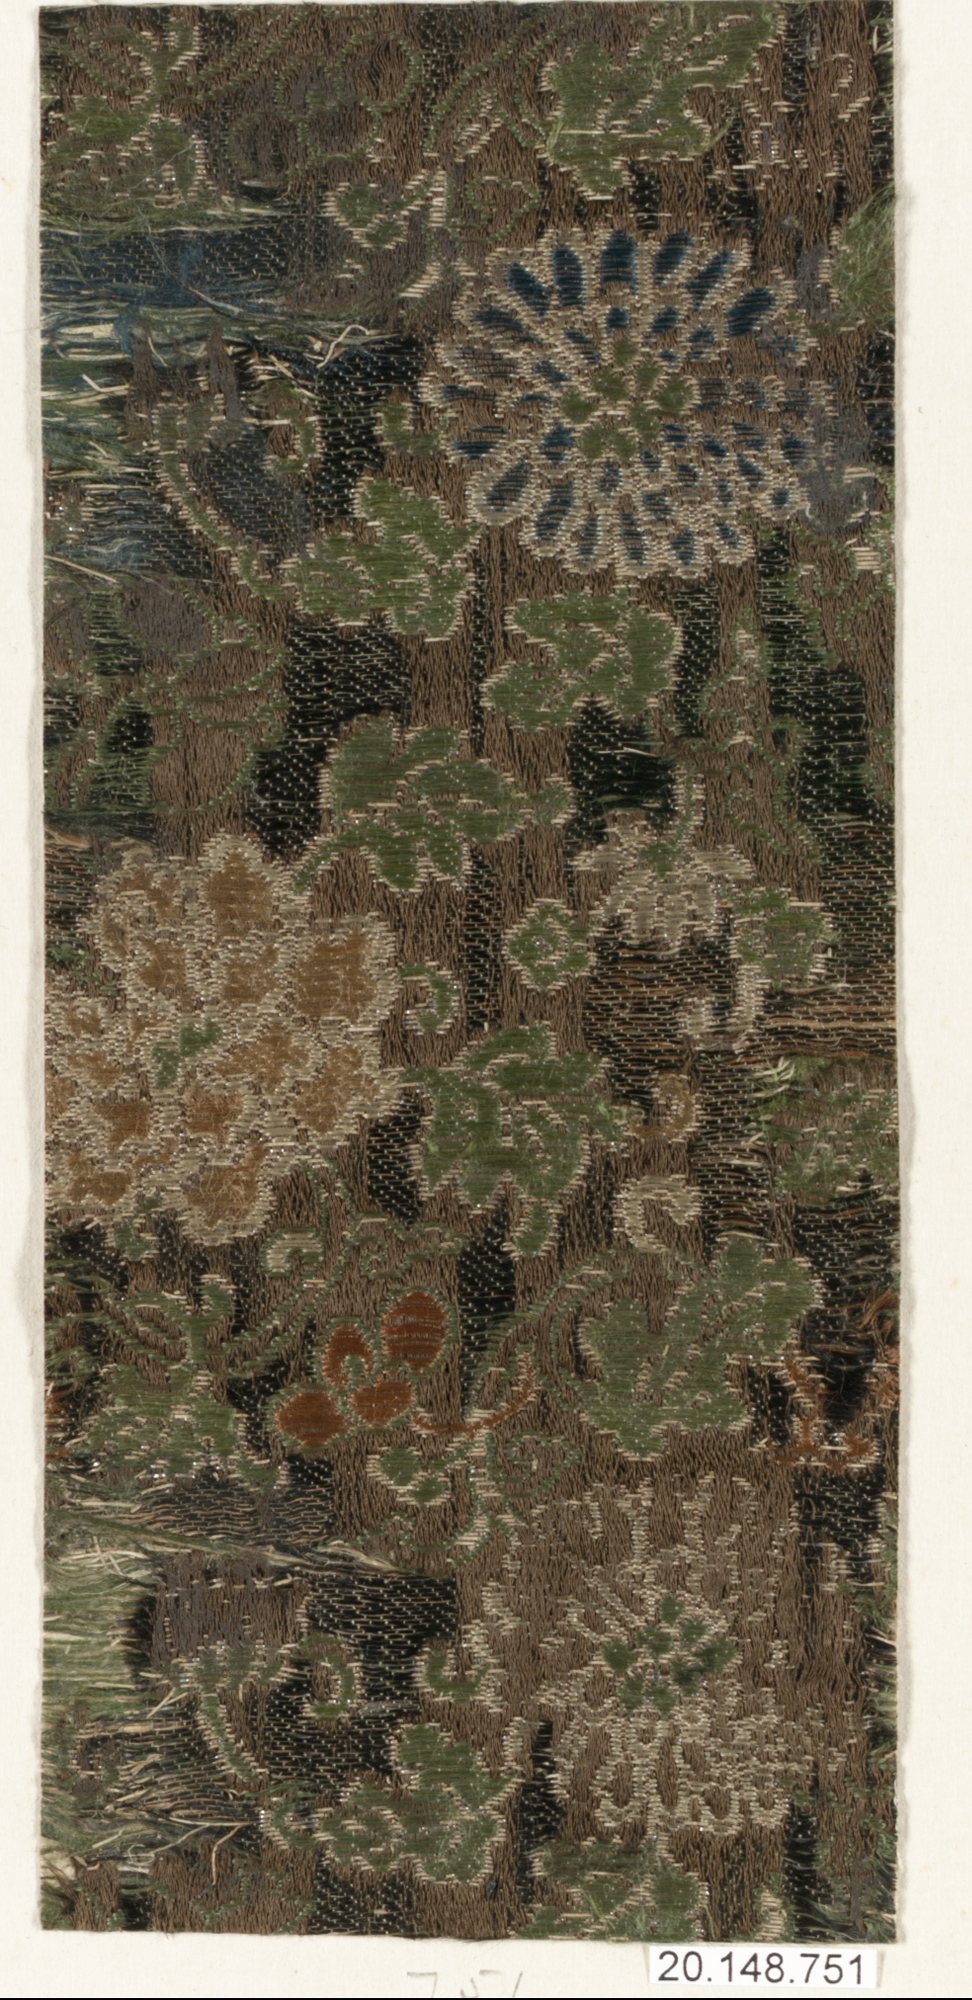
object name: piece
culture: chinese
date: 1601-1700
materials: silk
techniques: compound weave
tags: flowers,leaves